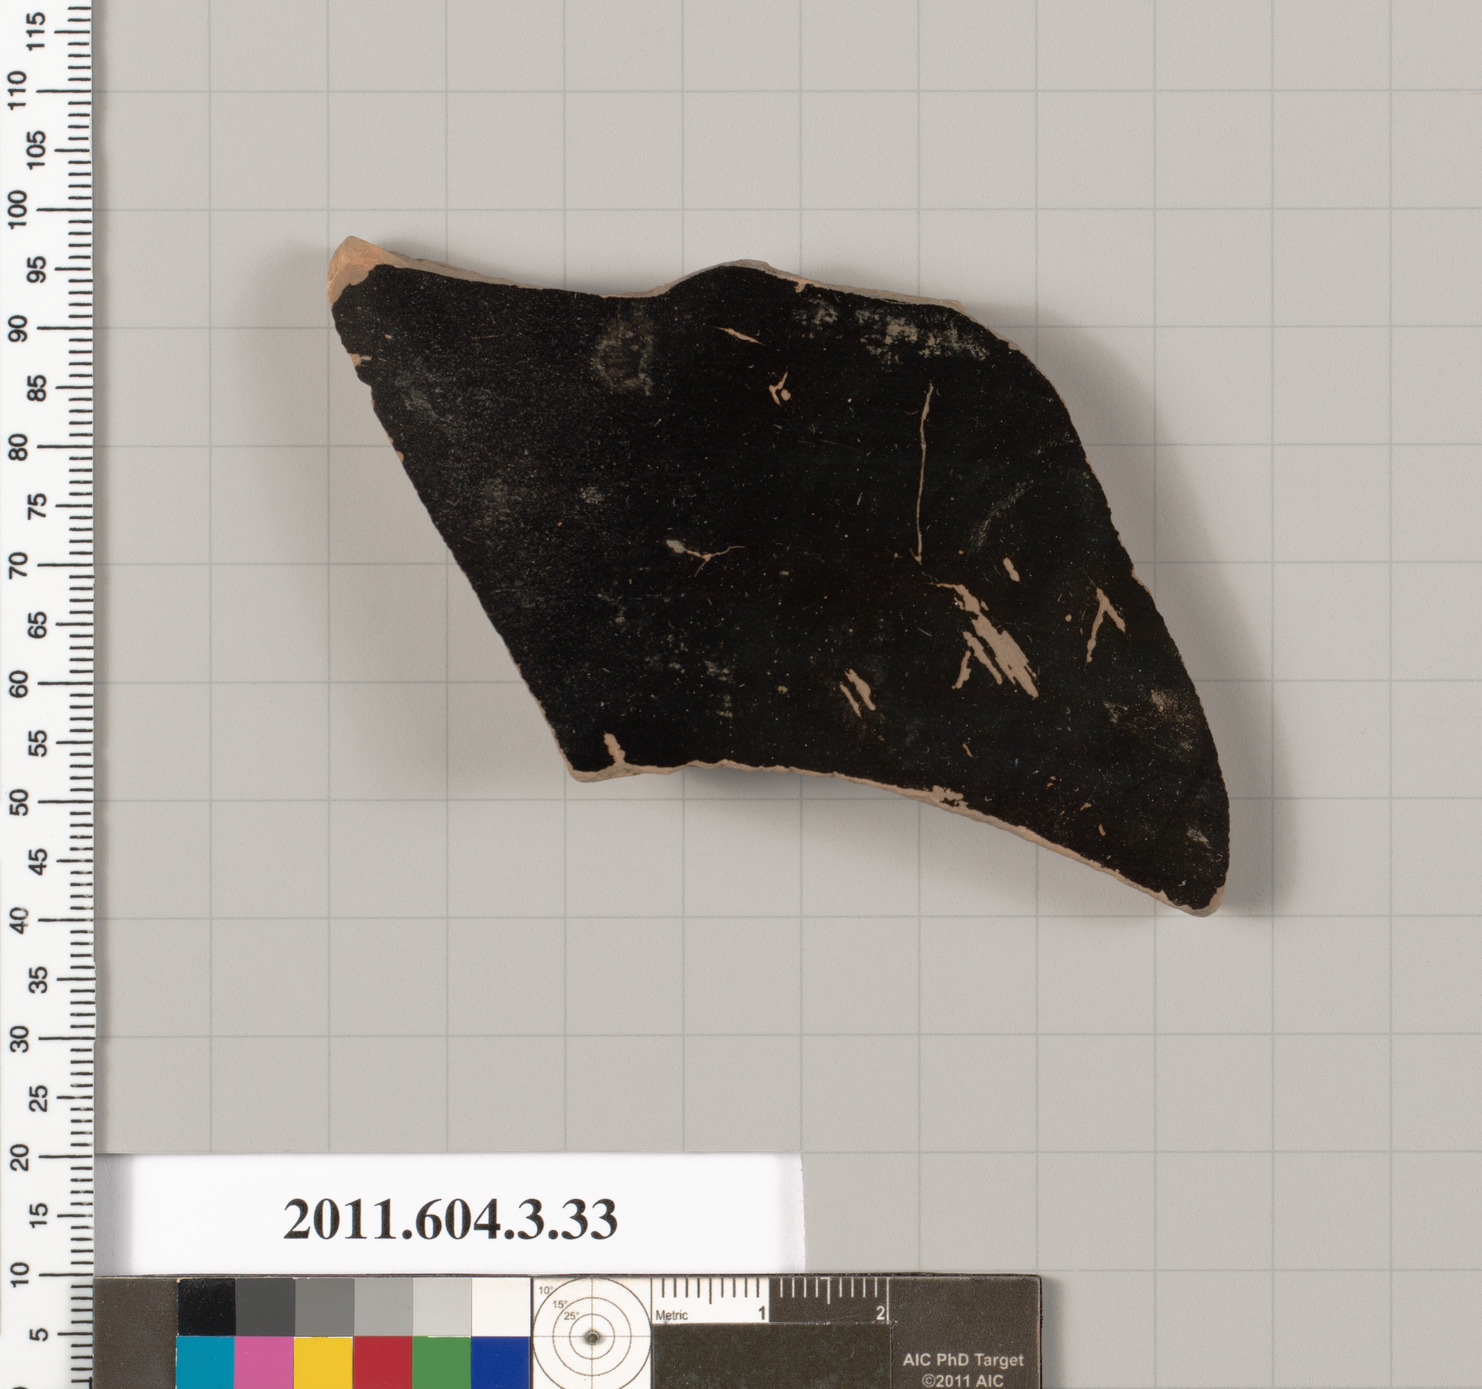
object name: amphora fragment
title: Terracotta fragment of an amphora (jar)?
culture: greek, attic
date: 600-501 BCE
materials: terracotta